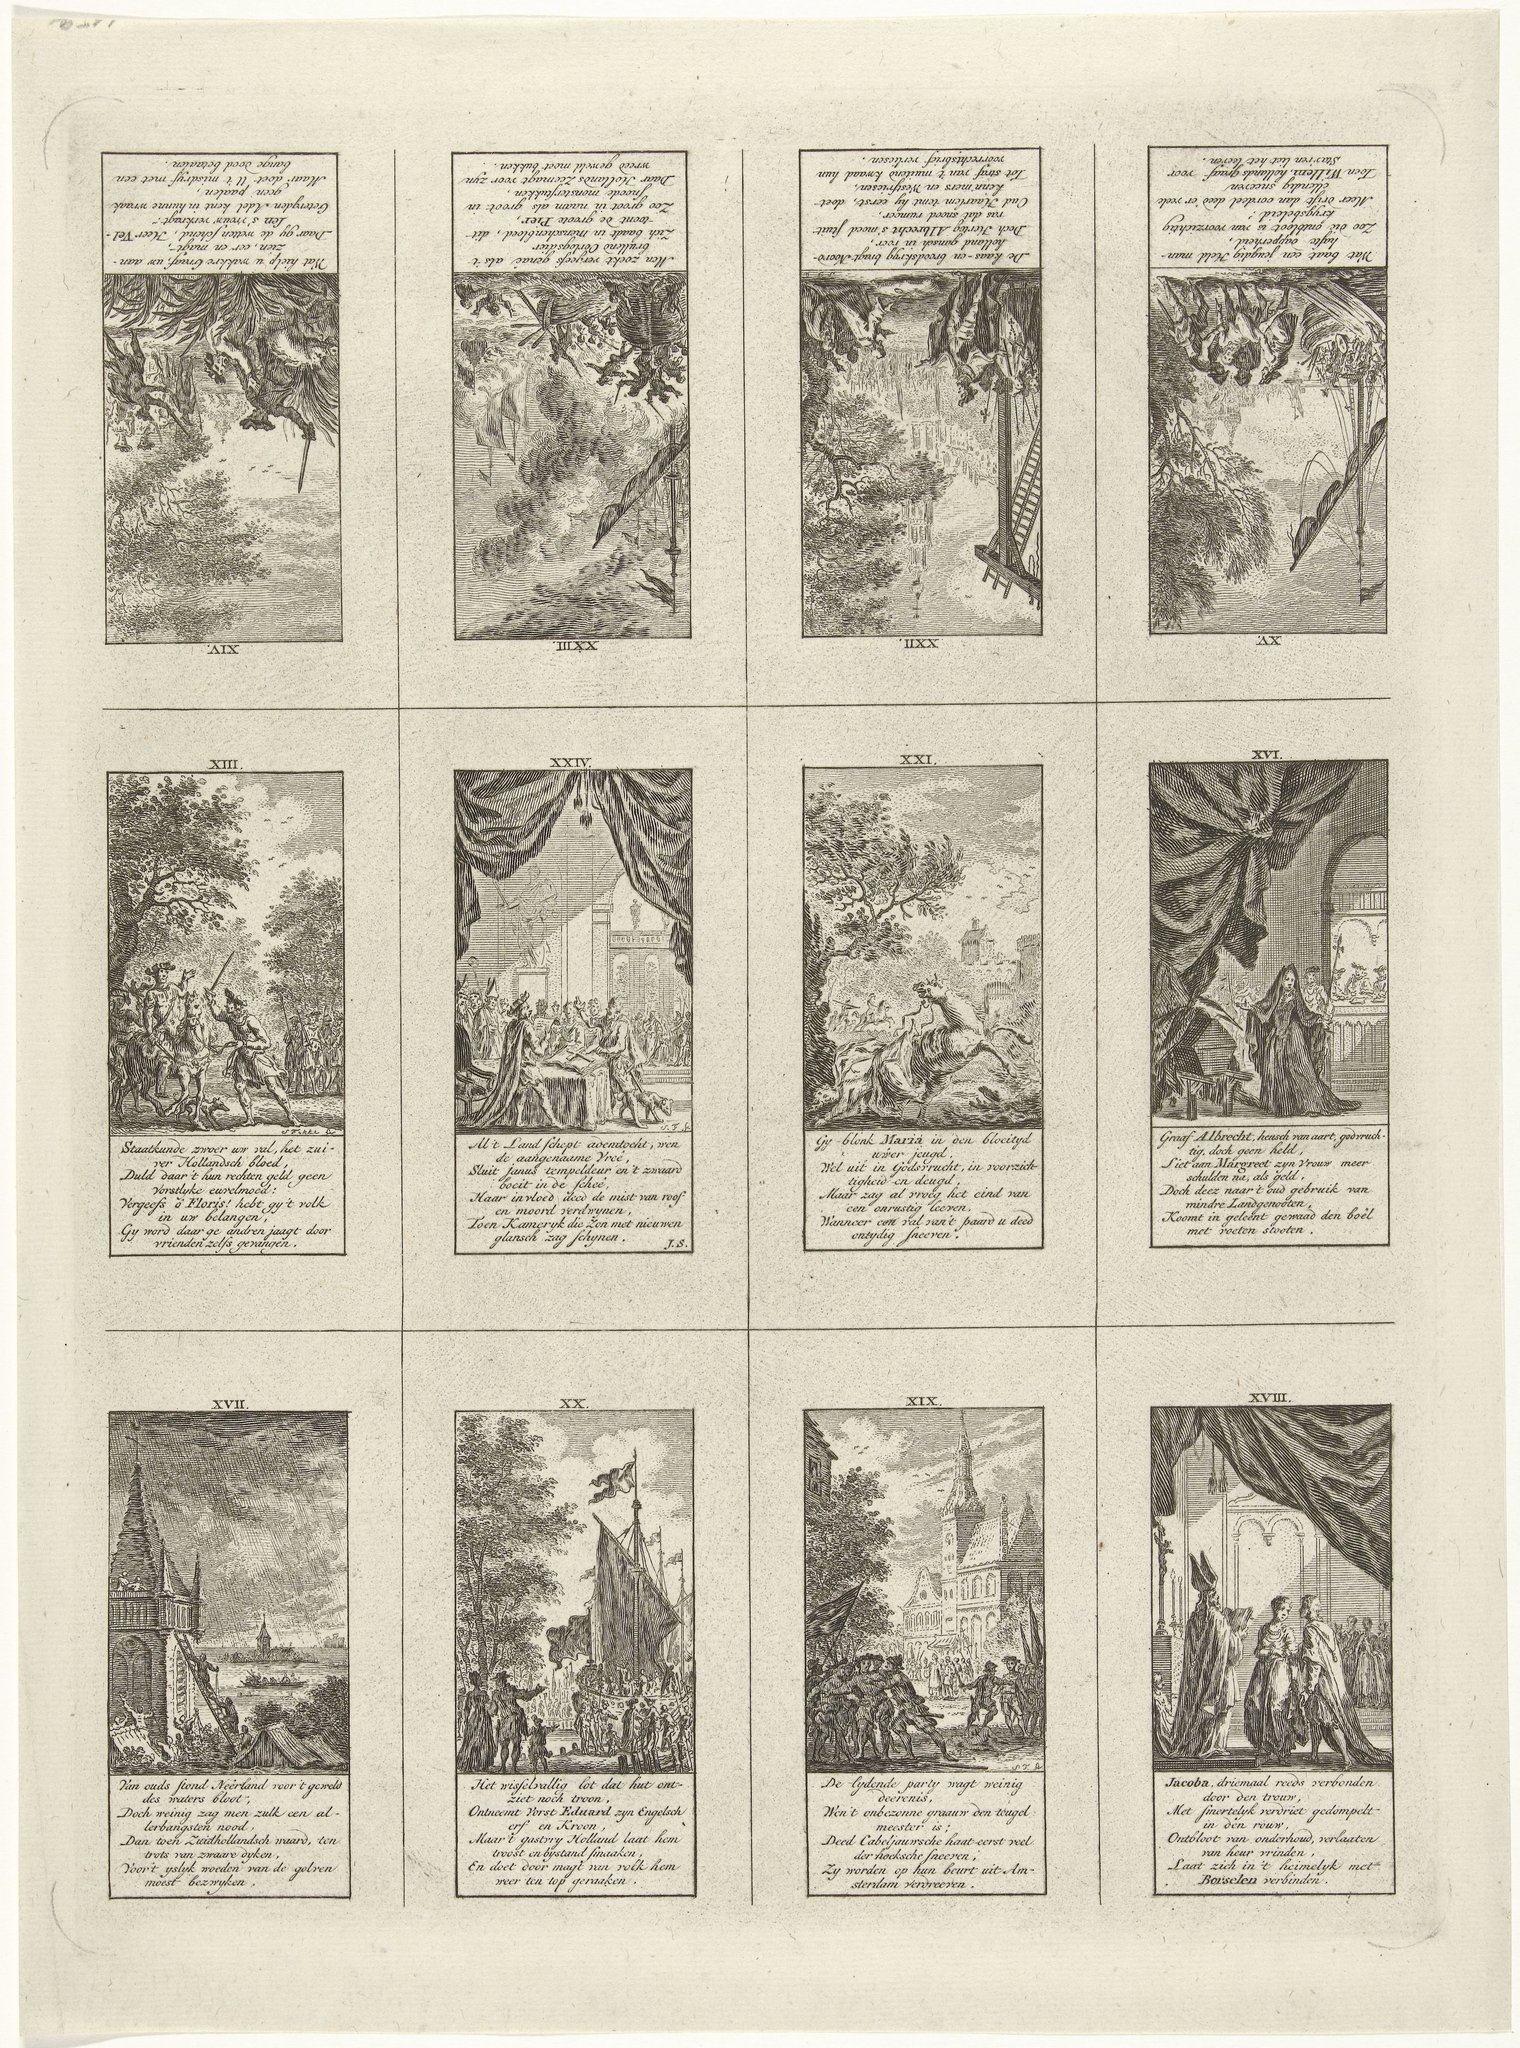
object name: print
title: Illustraties vaderlandse geschiedenis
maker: simon fokke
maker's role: draughtsman, print maker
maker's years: 1712-1784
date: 1722-1784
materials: paper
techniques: etching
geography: amsterdam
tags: historical events and situations, historical persons (portraits and scenes from the life)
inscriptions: collector's mark: Lugt 2228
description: Onversneden blad met twaalf voorstellingen uit de vaderlandse geschiedenis. De afbeeldingen zijn middenboven genummerd van XIII tot en met XXIV en voorzien van toelichtende onderschriften.